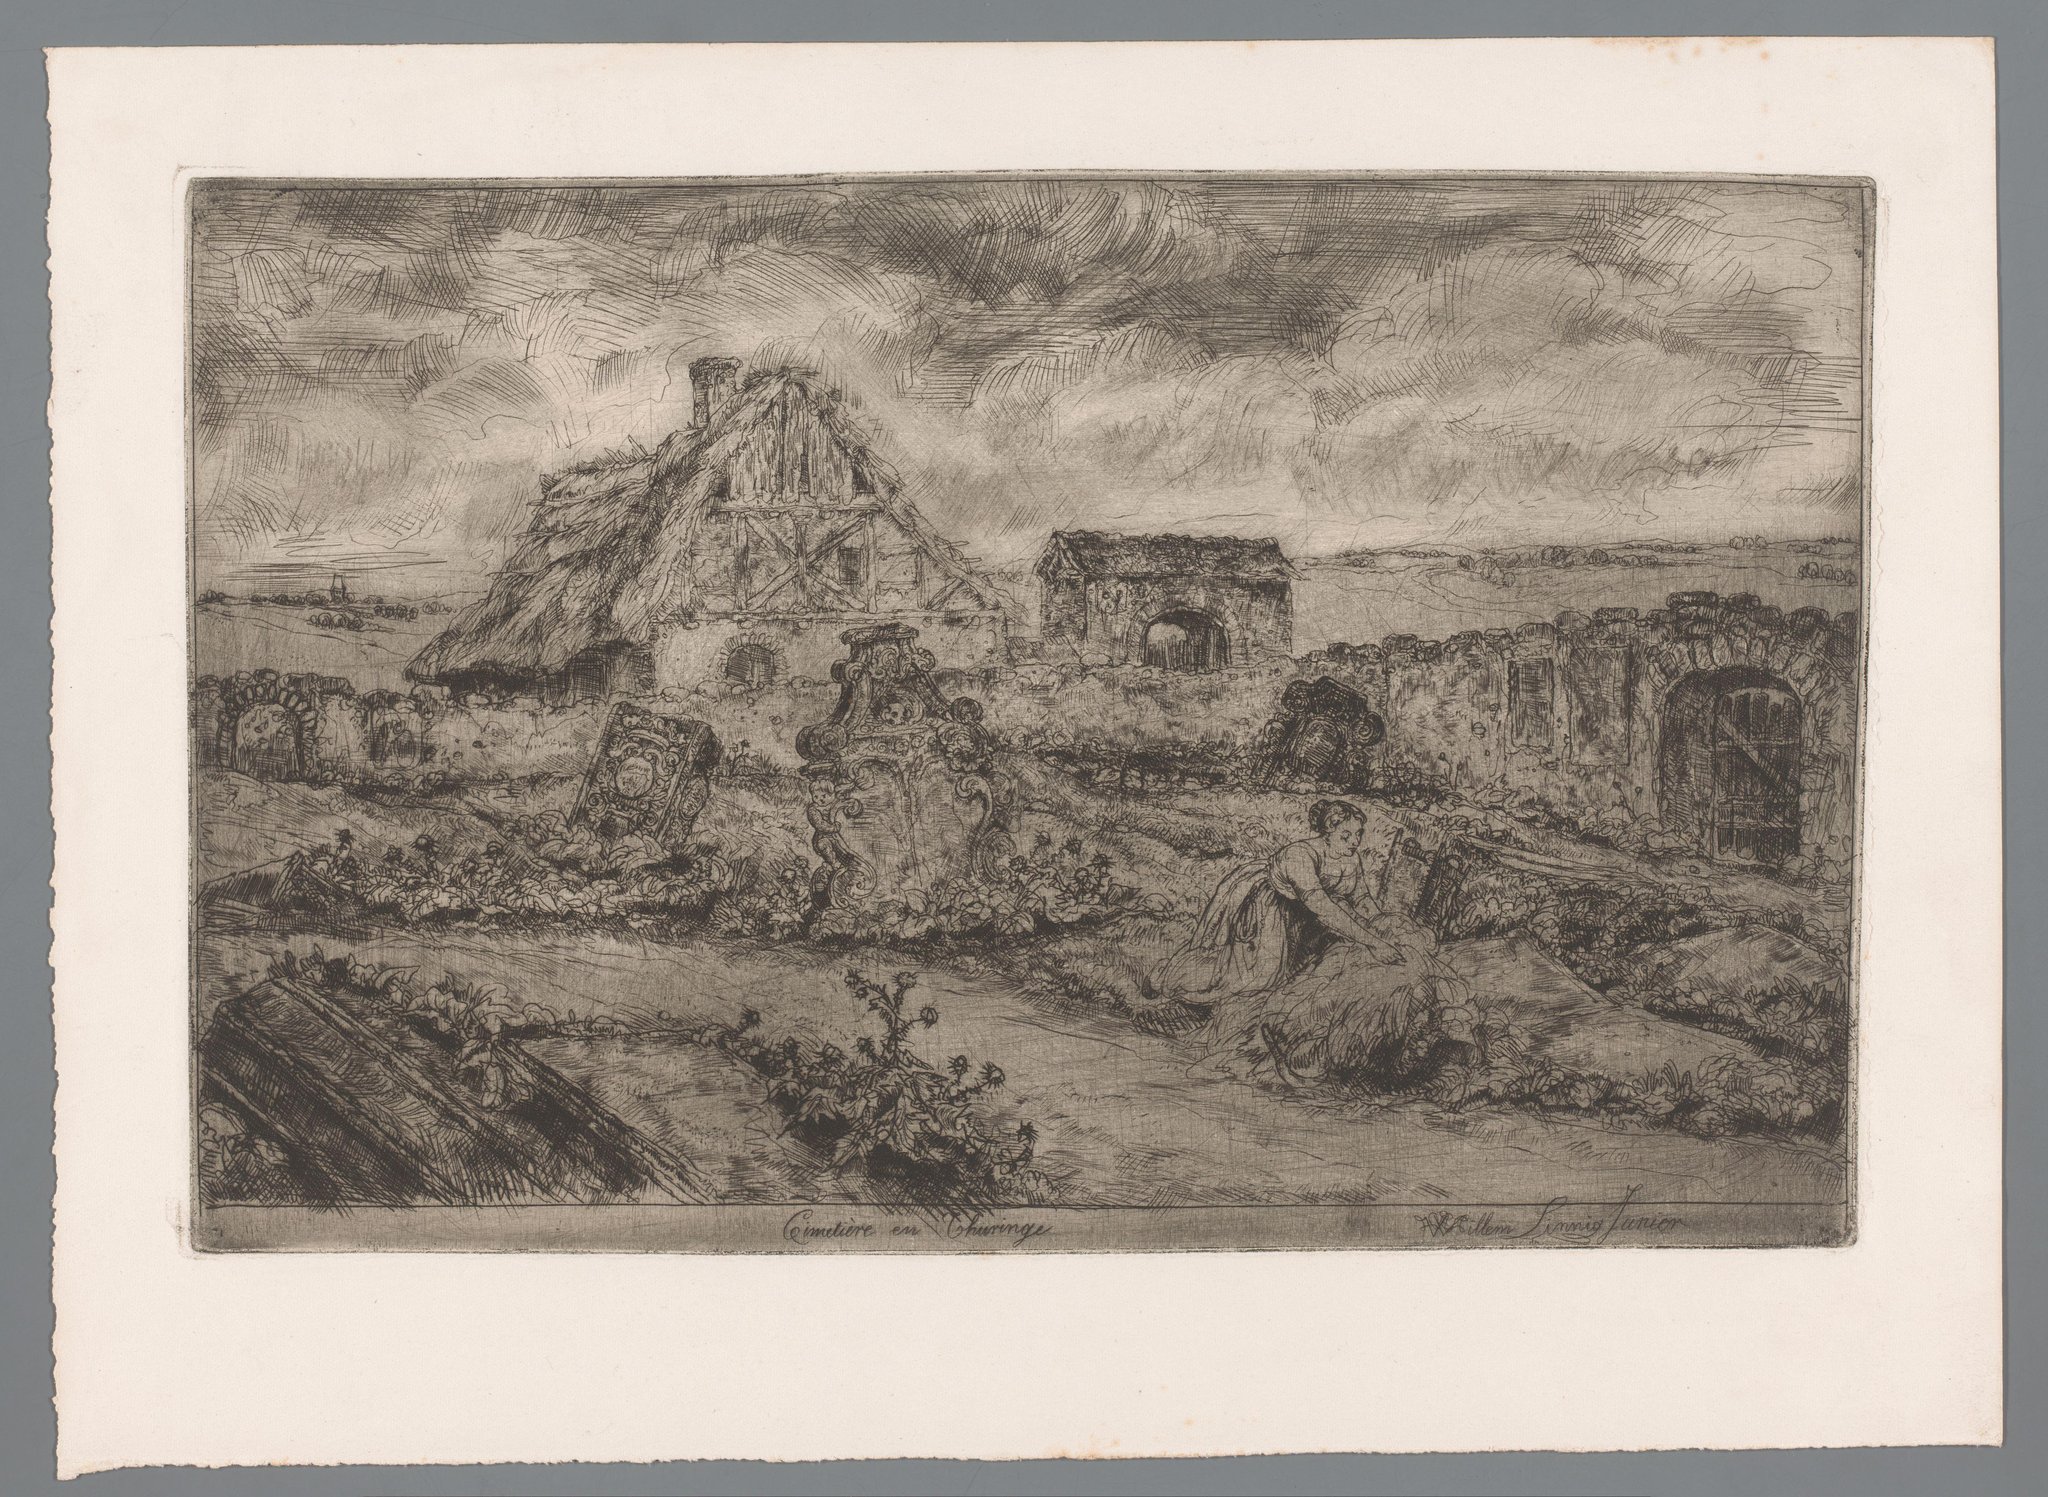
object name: print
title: Cimetière en Thuringe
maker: willem linnig (ii)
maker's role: print maker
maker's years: 1842-1890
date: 1876-1889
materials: paper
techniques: drypoint, etching, intaglio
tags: churchyard, cemetery, farm or solitary house in landscape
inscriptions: collector's mark: Lugt 2228